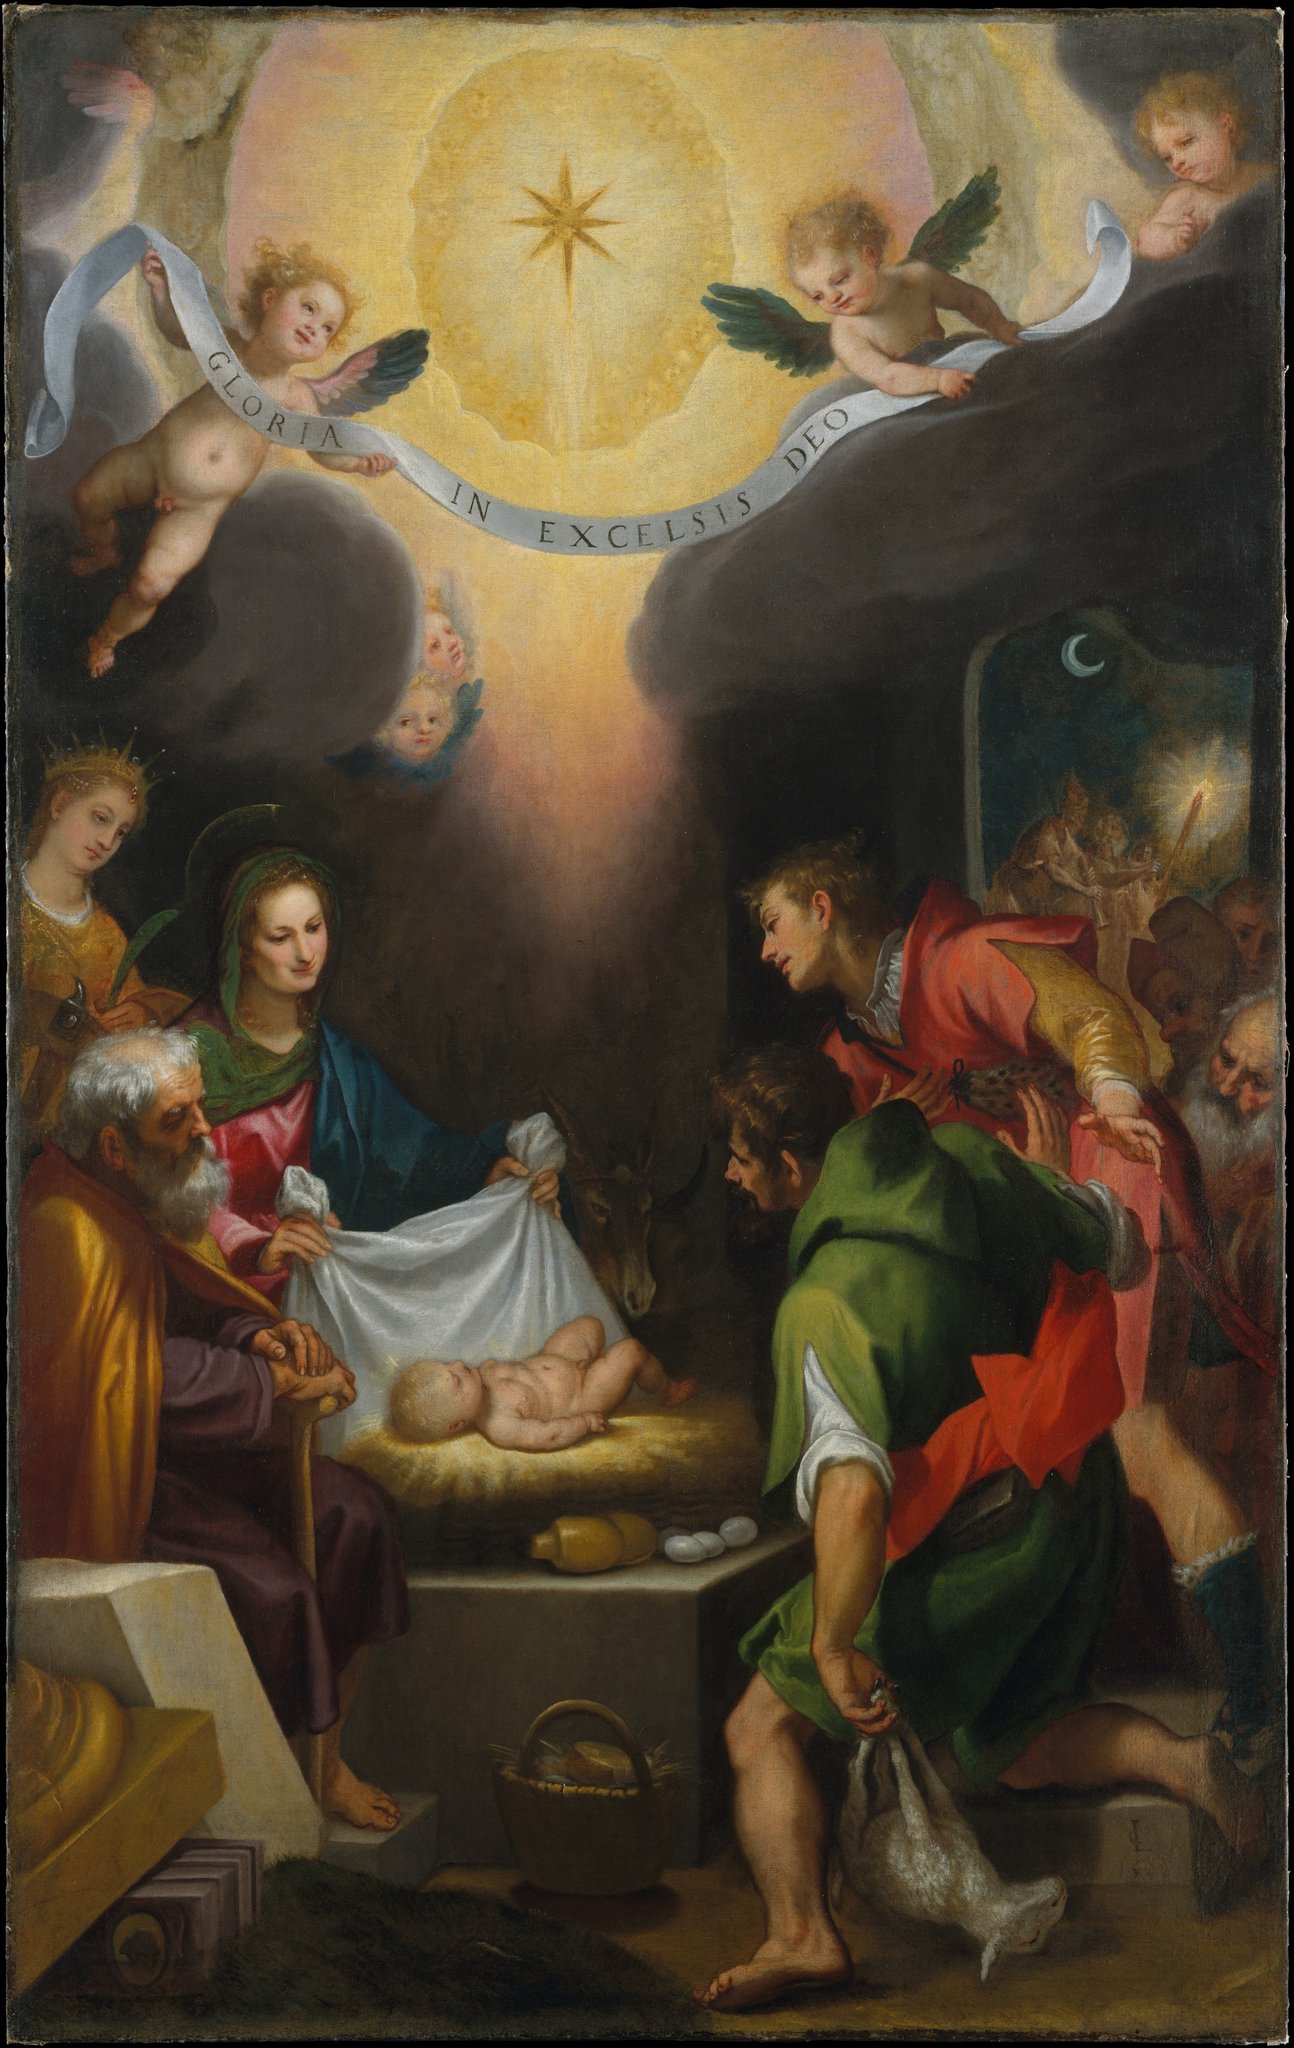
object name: painting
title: The Adoration of the Shepherds with Saint Catherine of Alexandria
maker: cigoli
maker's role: artist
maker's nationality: italian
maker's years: 1559-1613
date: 1599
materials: canvas, oil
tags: sheep,angels,saint catherine,virgin mary,jesus,adoration of the shepherds,joseph